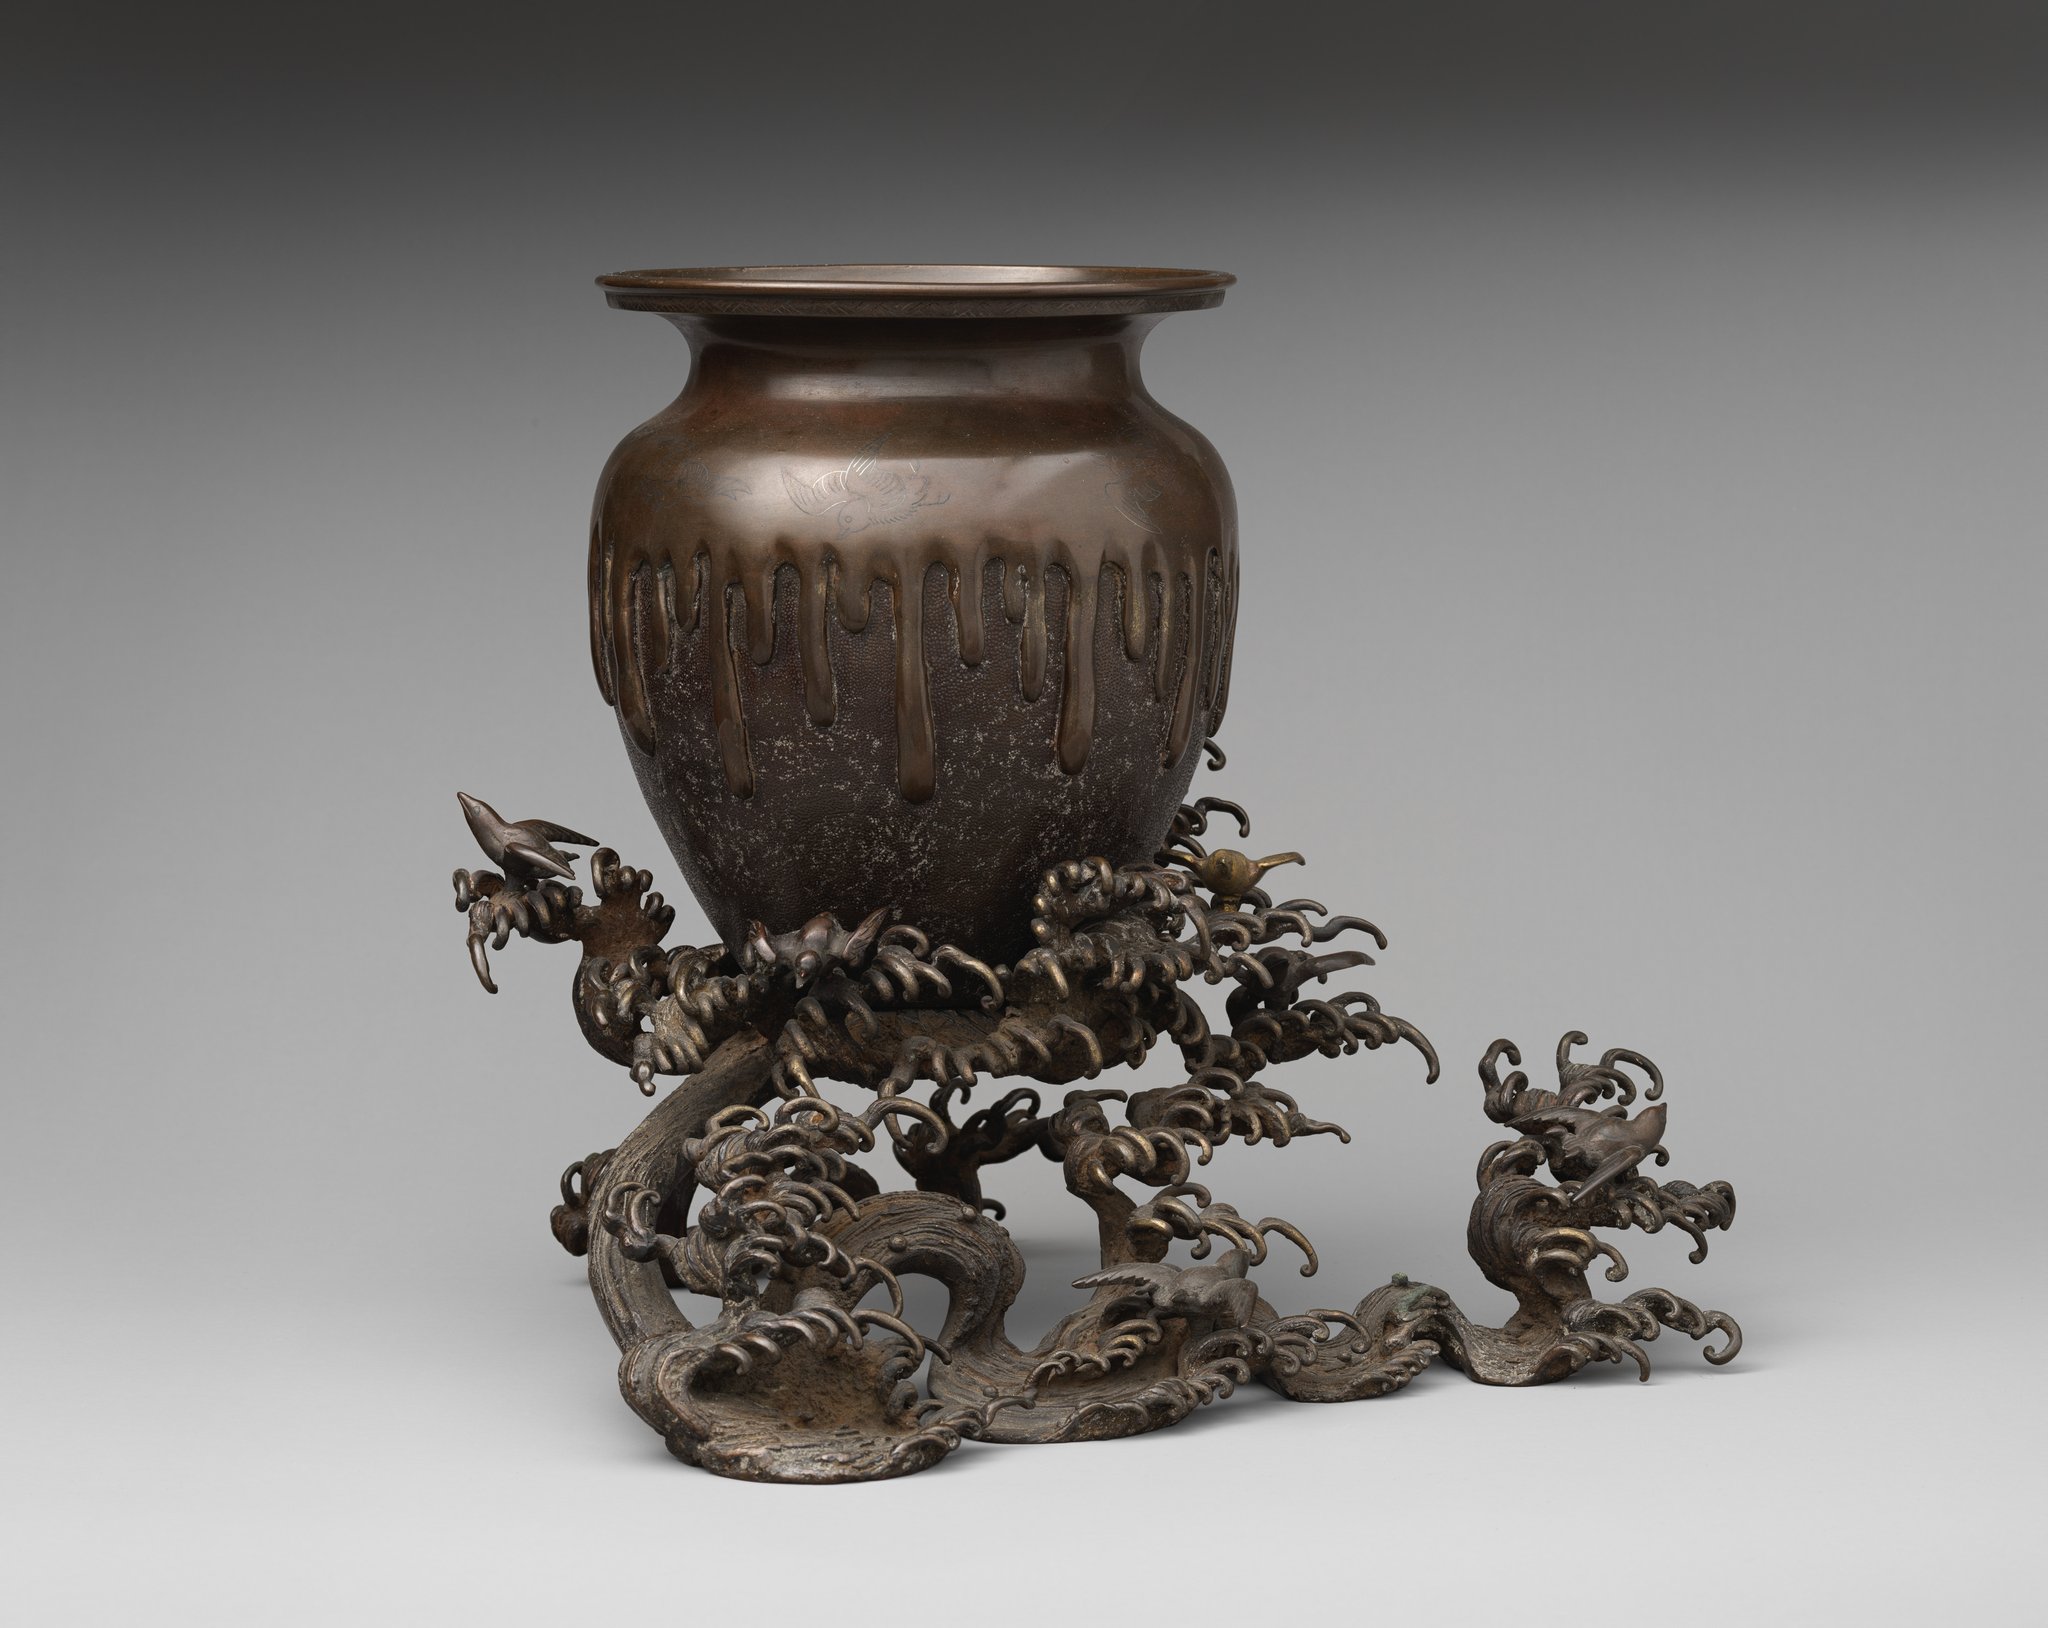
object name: vase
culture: japanese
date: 1851-1900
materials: copper alloy, silver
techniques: inlay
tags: birds,waves